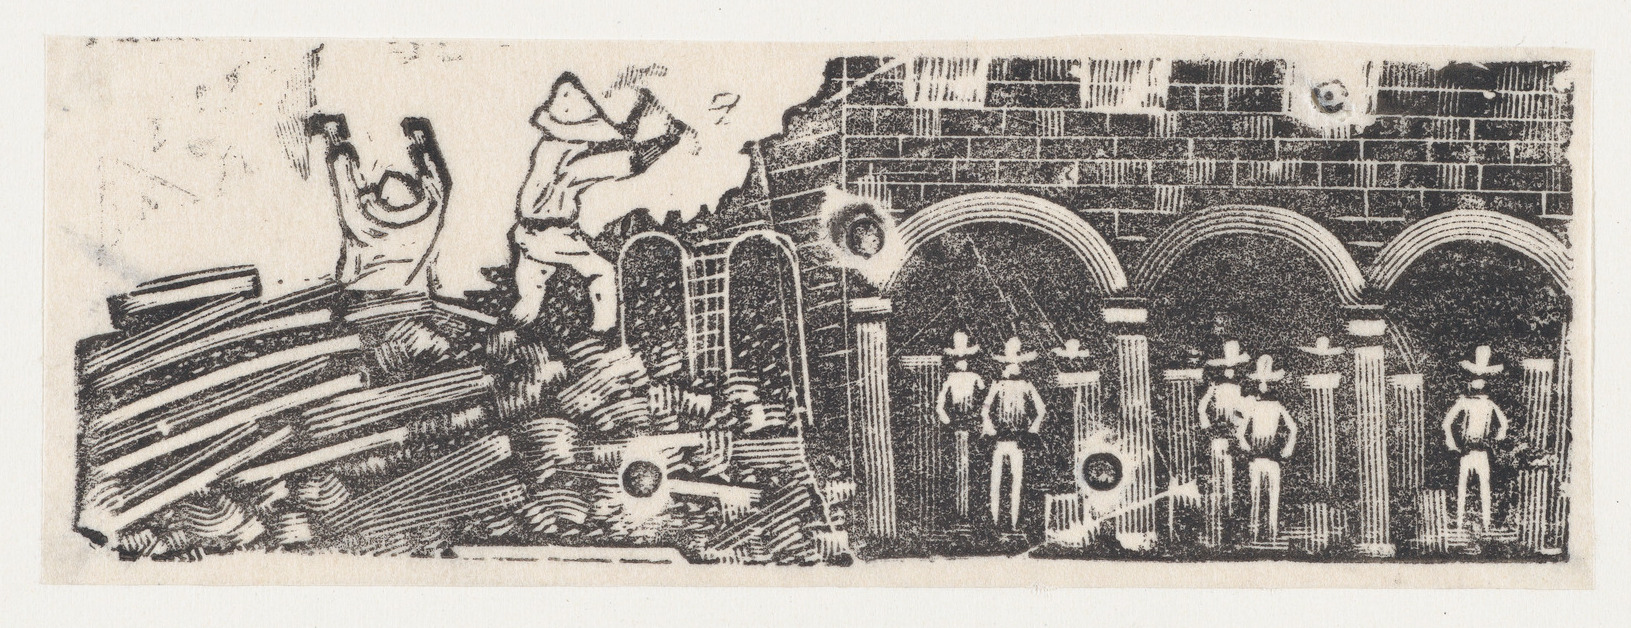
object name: print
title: A pair of workers atop a pile of rubble and other workers watching them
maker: josé guadalupe posada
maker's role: artist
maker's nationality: mexican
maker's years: 1852-1913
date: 1880-1910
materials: metal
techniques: engraving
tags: men,working